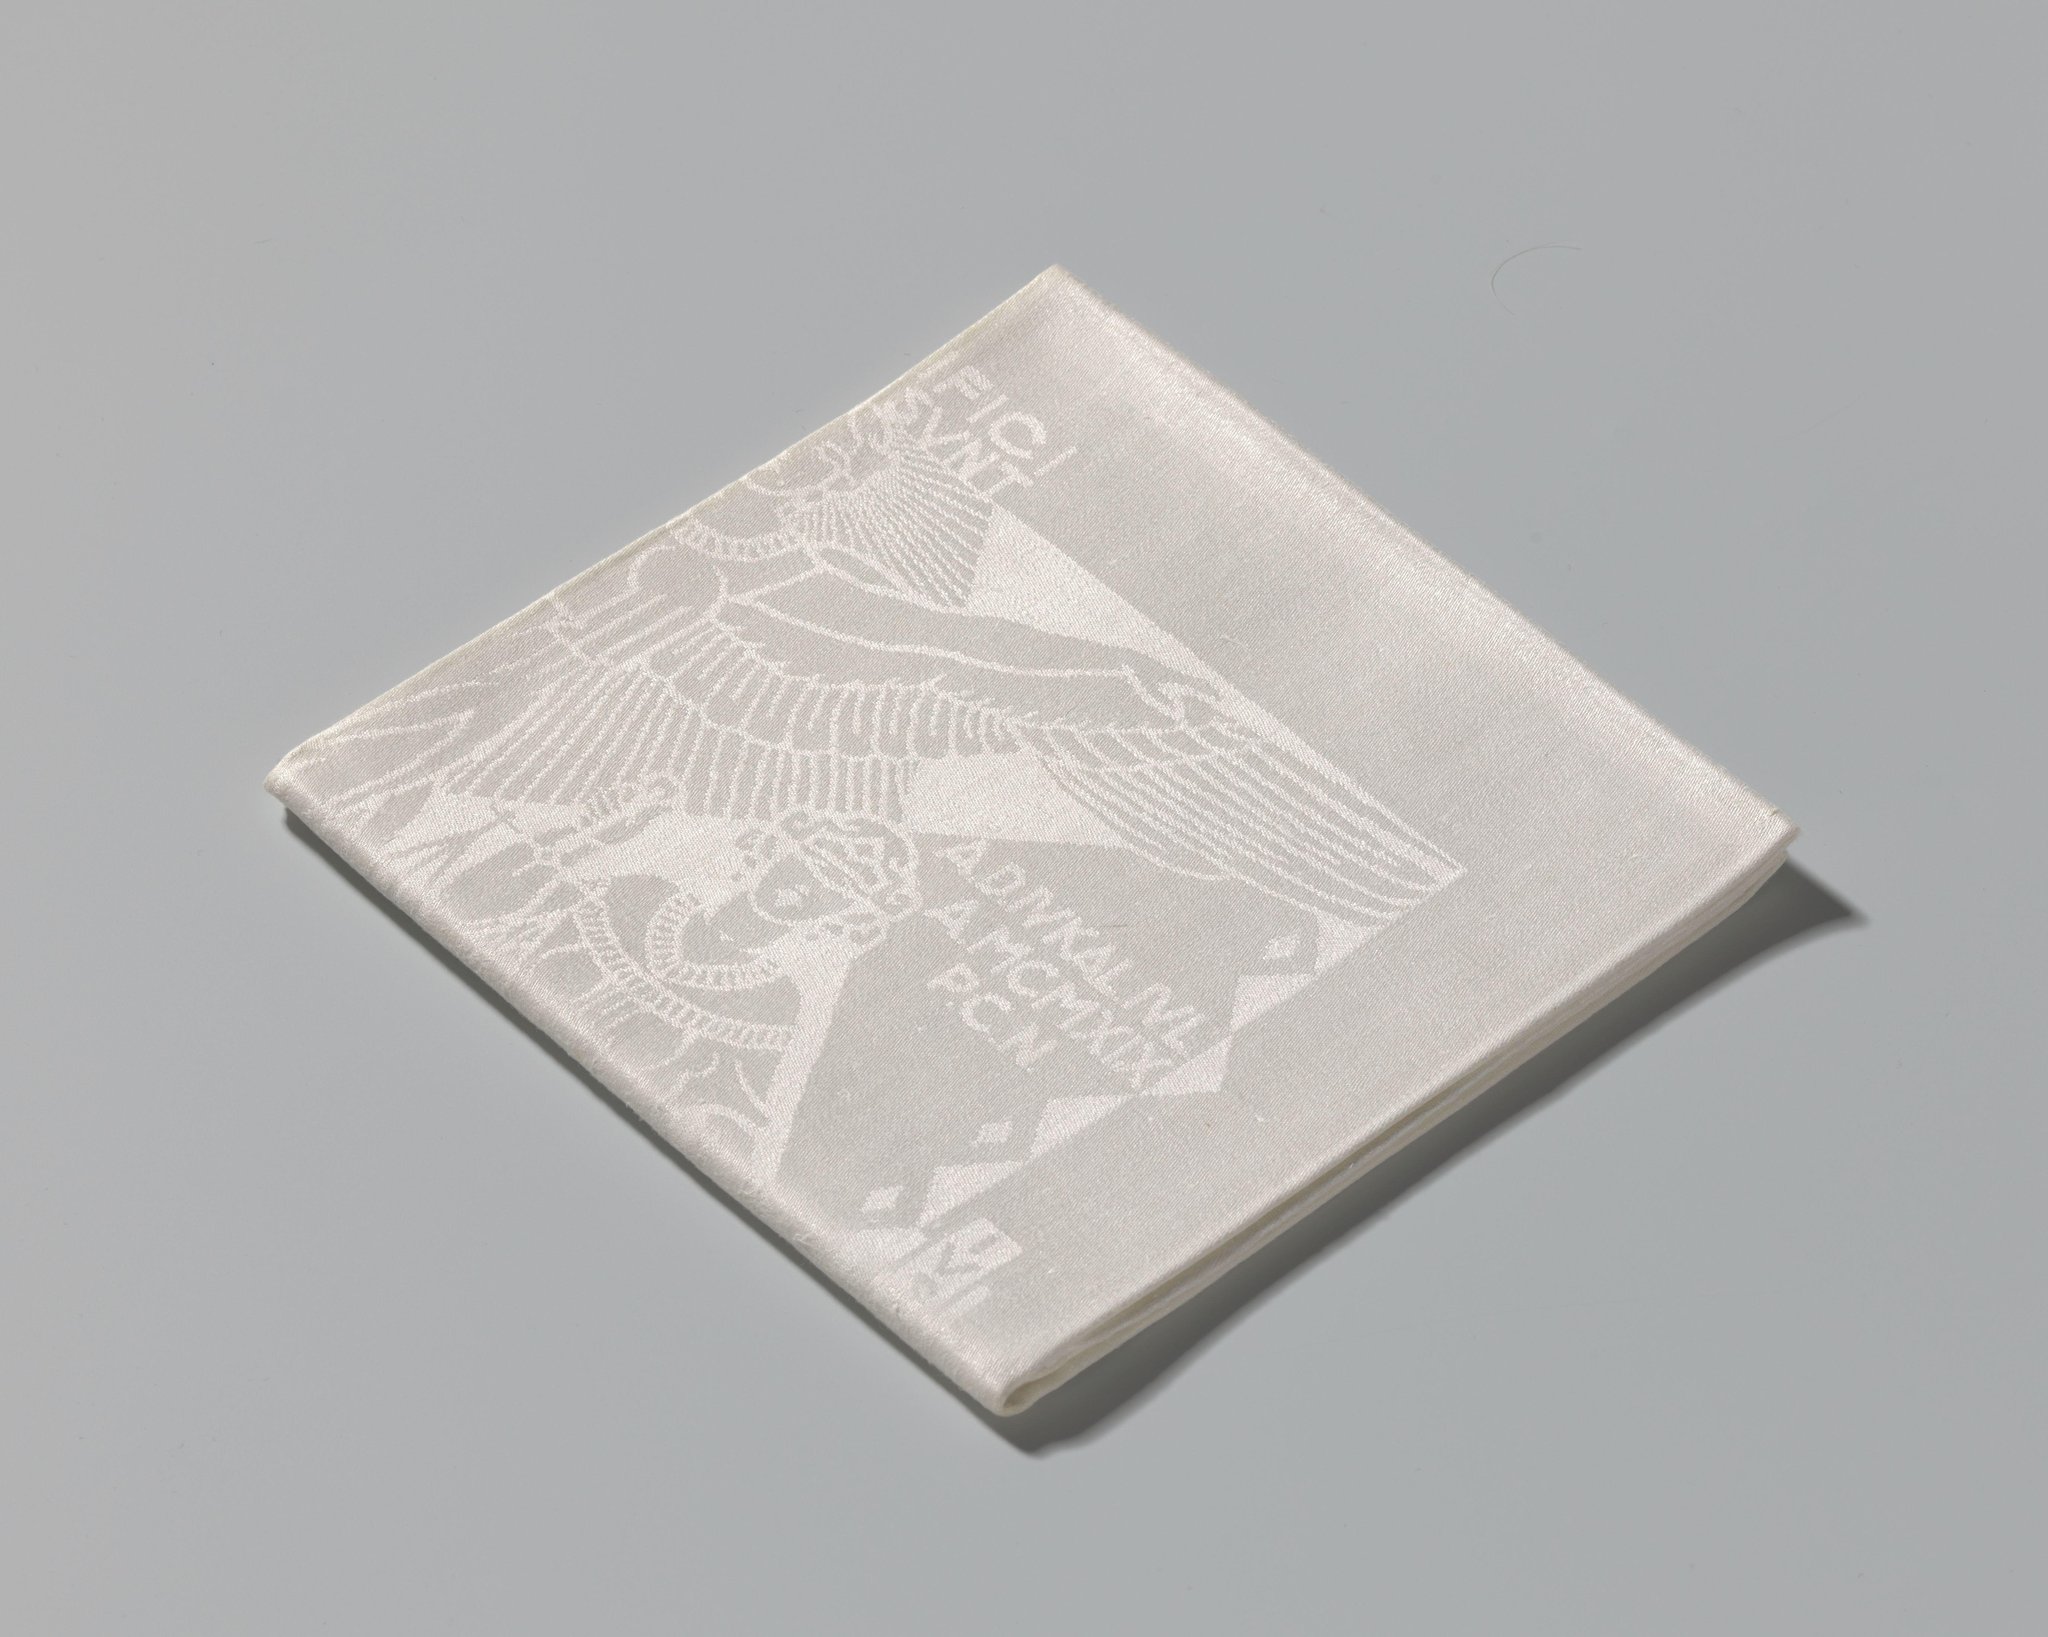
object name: napkin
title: Servet van wit linnendamast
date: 1919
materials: linen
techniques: damask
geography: netherlands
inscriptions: number: ‘558’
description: Wit linnen damasten servet met de Vrede van Versailles.